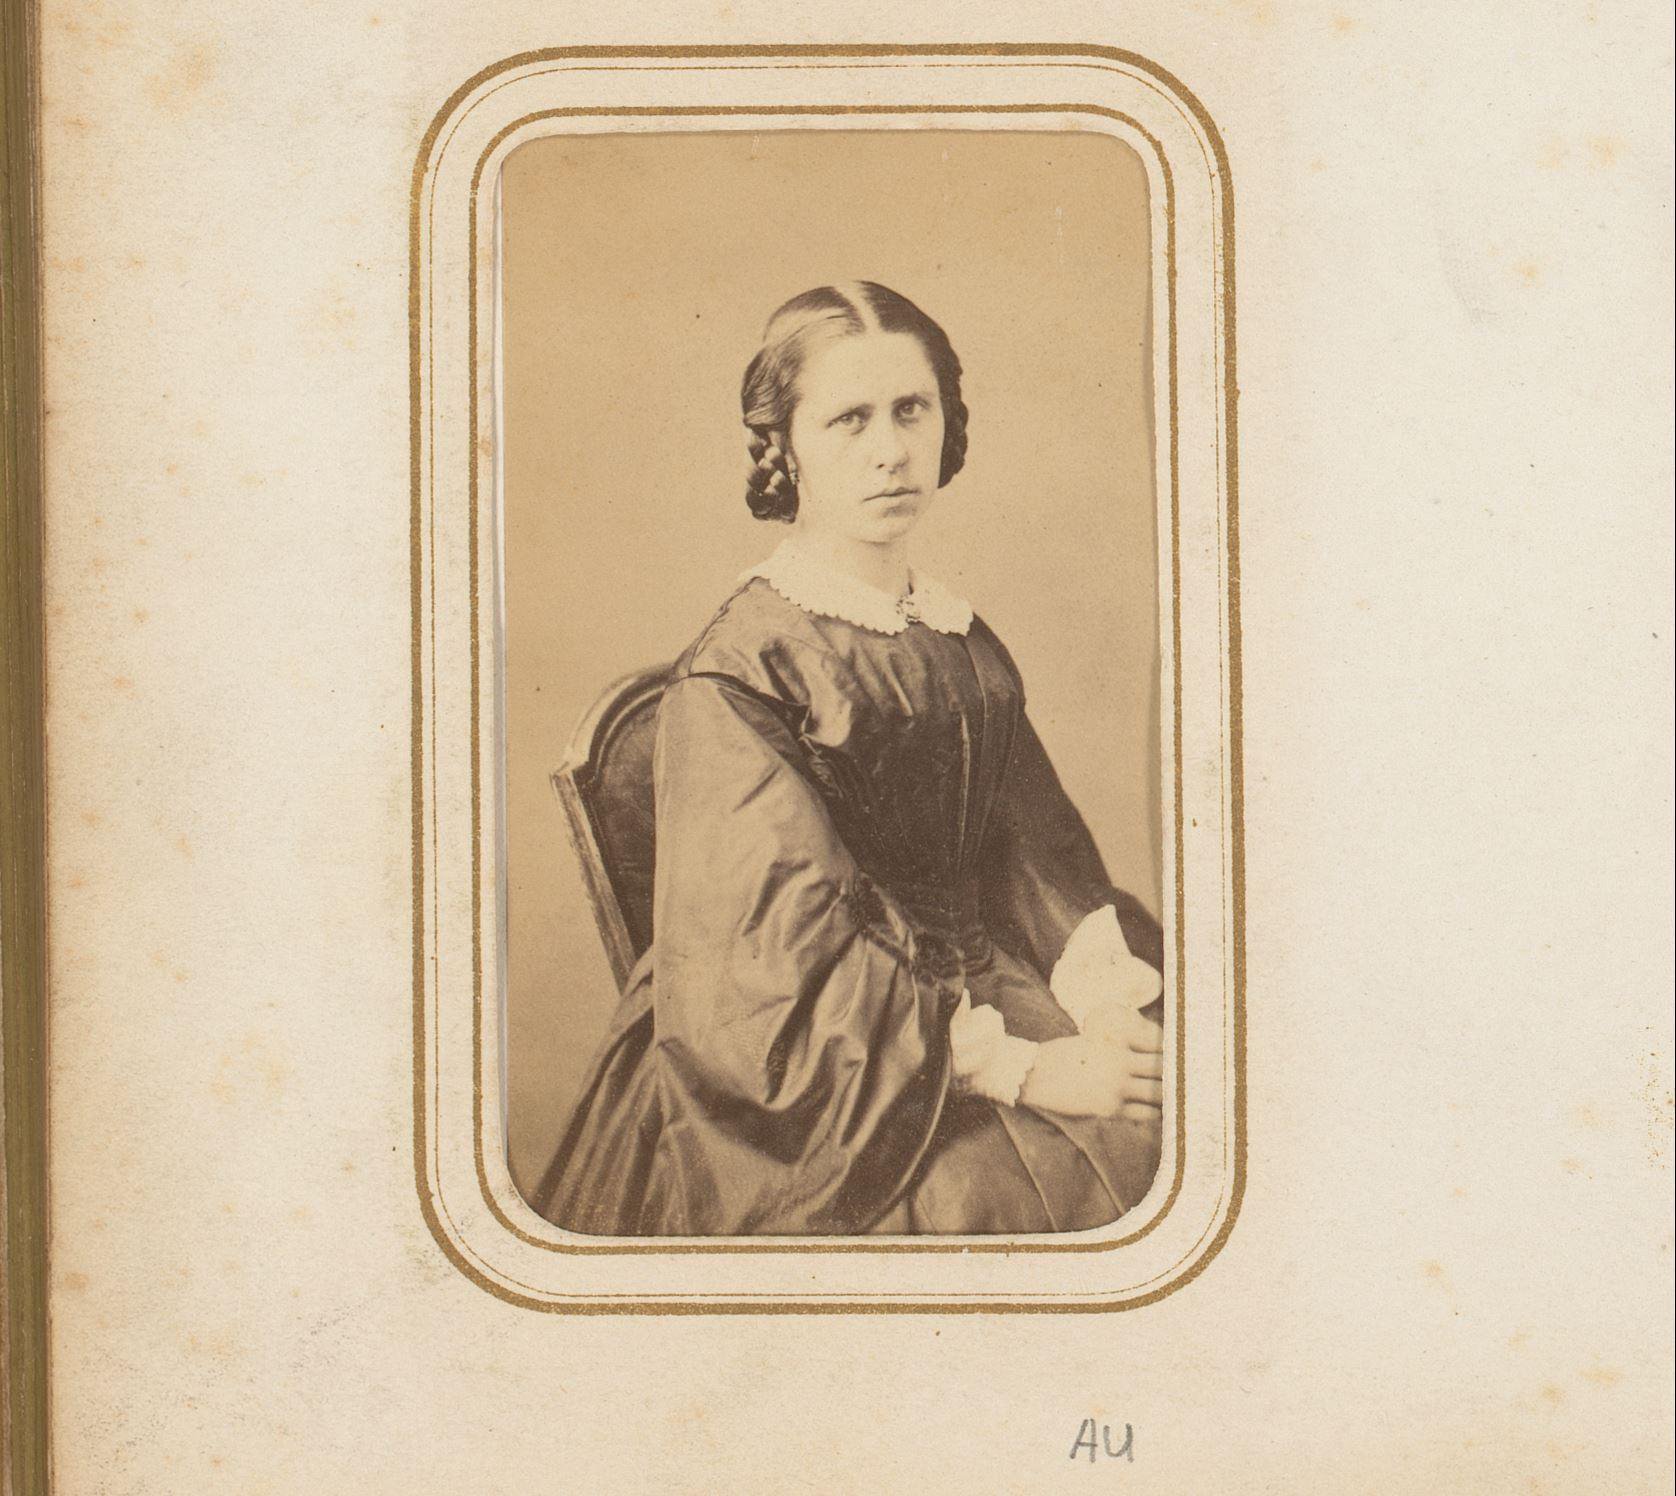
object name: album leaf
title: Portret van een zittende vrouw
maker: alphonse plumier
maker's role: fotograaf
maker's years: 1819-1877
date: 1850-1877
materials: cardboard, photographic support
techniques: albumen print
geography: brussels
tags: sitting figure - aa - female human figure, historical persons - bb - woman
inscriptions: inscription: ‘Alph. Plumier/ Photographe/ Passage St. Hubert, 27, et rue d'Arenberg/ Bruxelles’